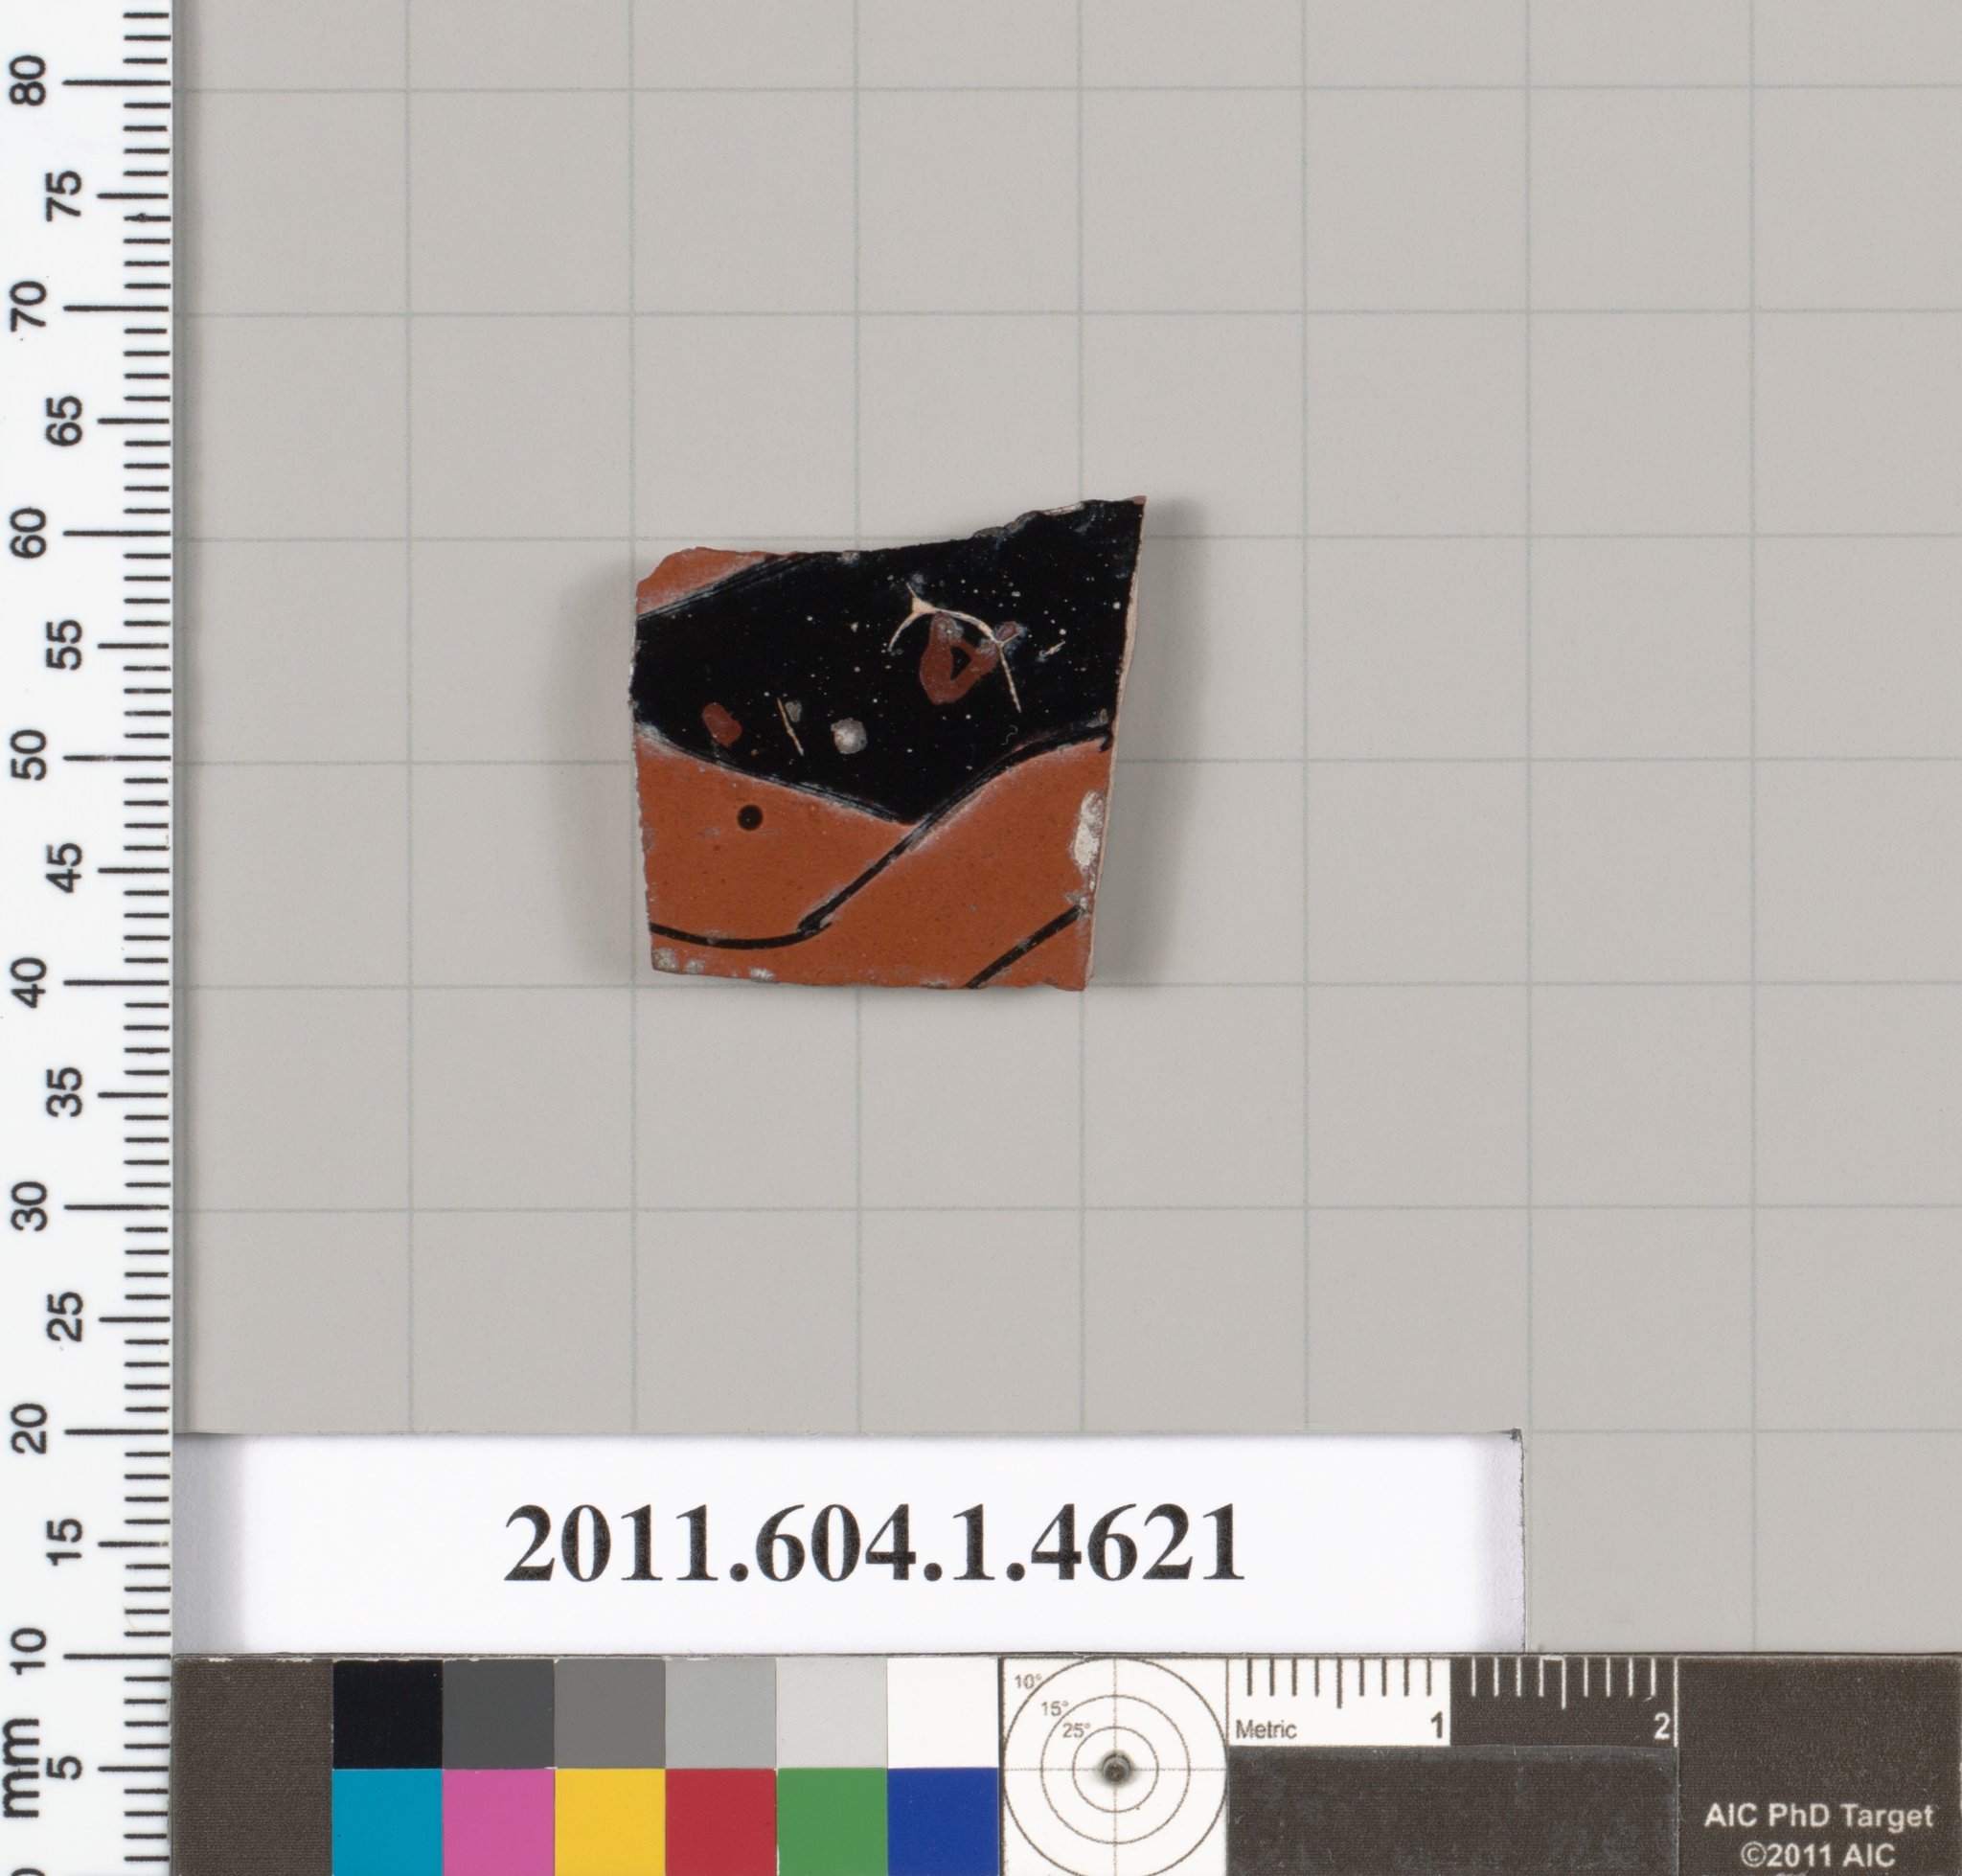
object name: kylix fragment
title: Terracotta fragment of a kylix (drinking cup)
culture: greek, attic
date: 520-500 BCE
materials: terracotta